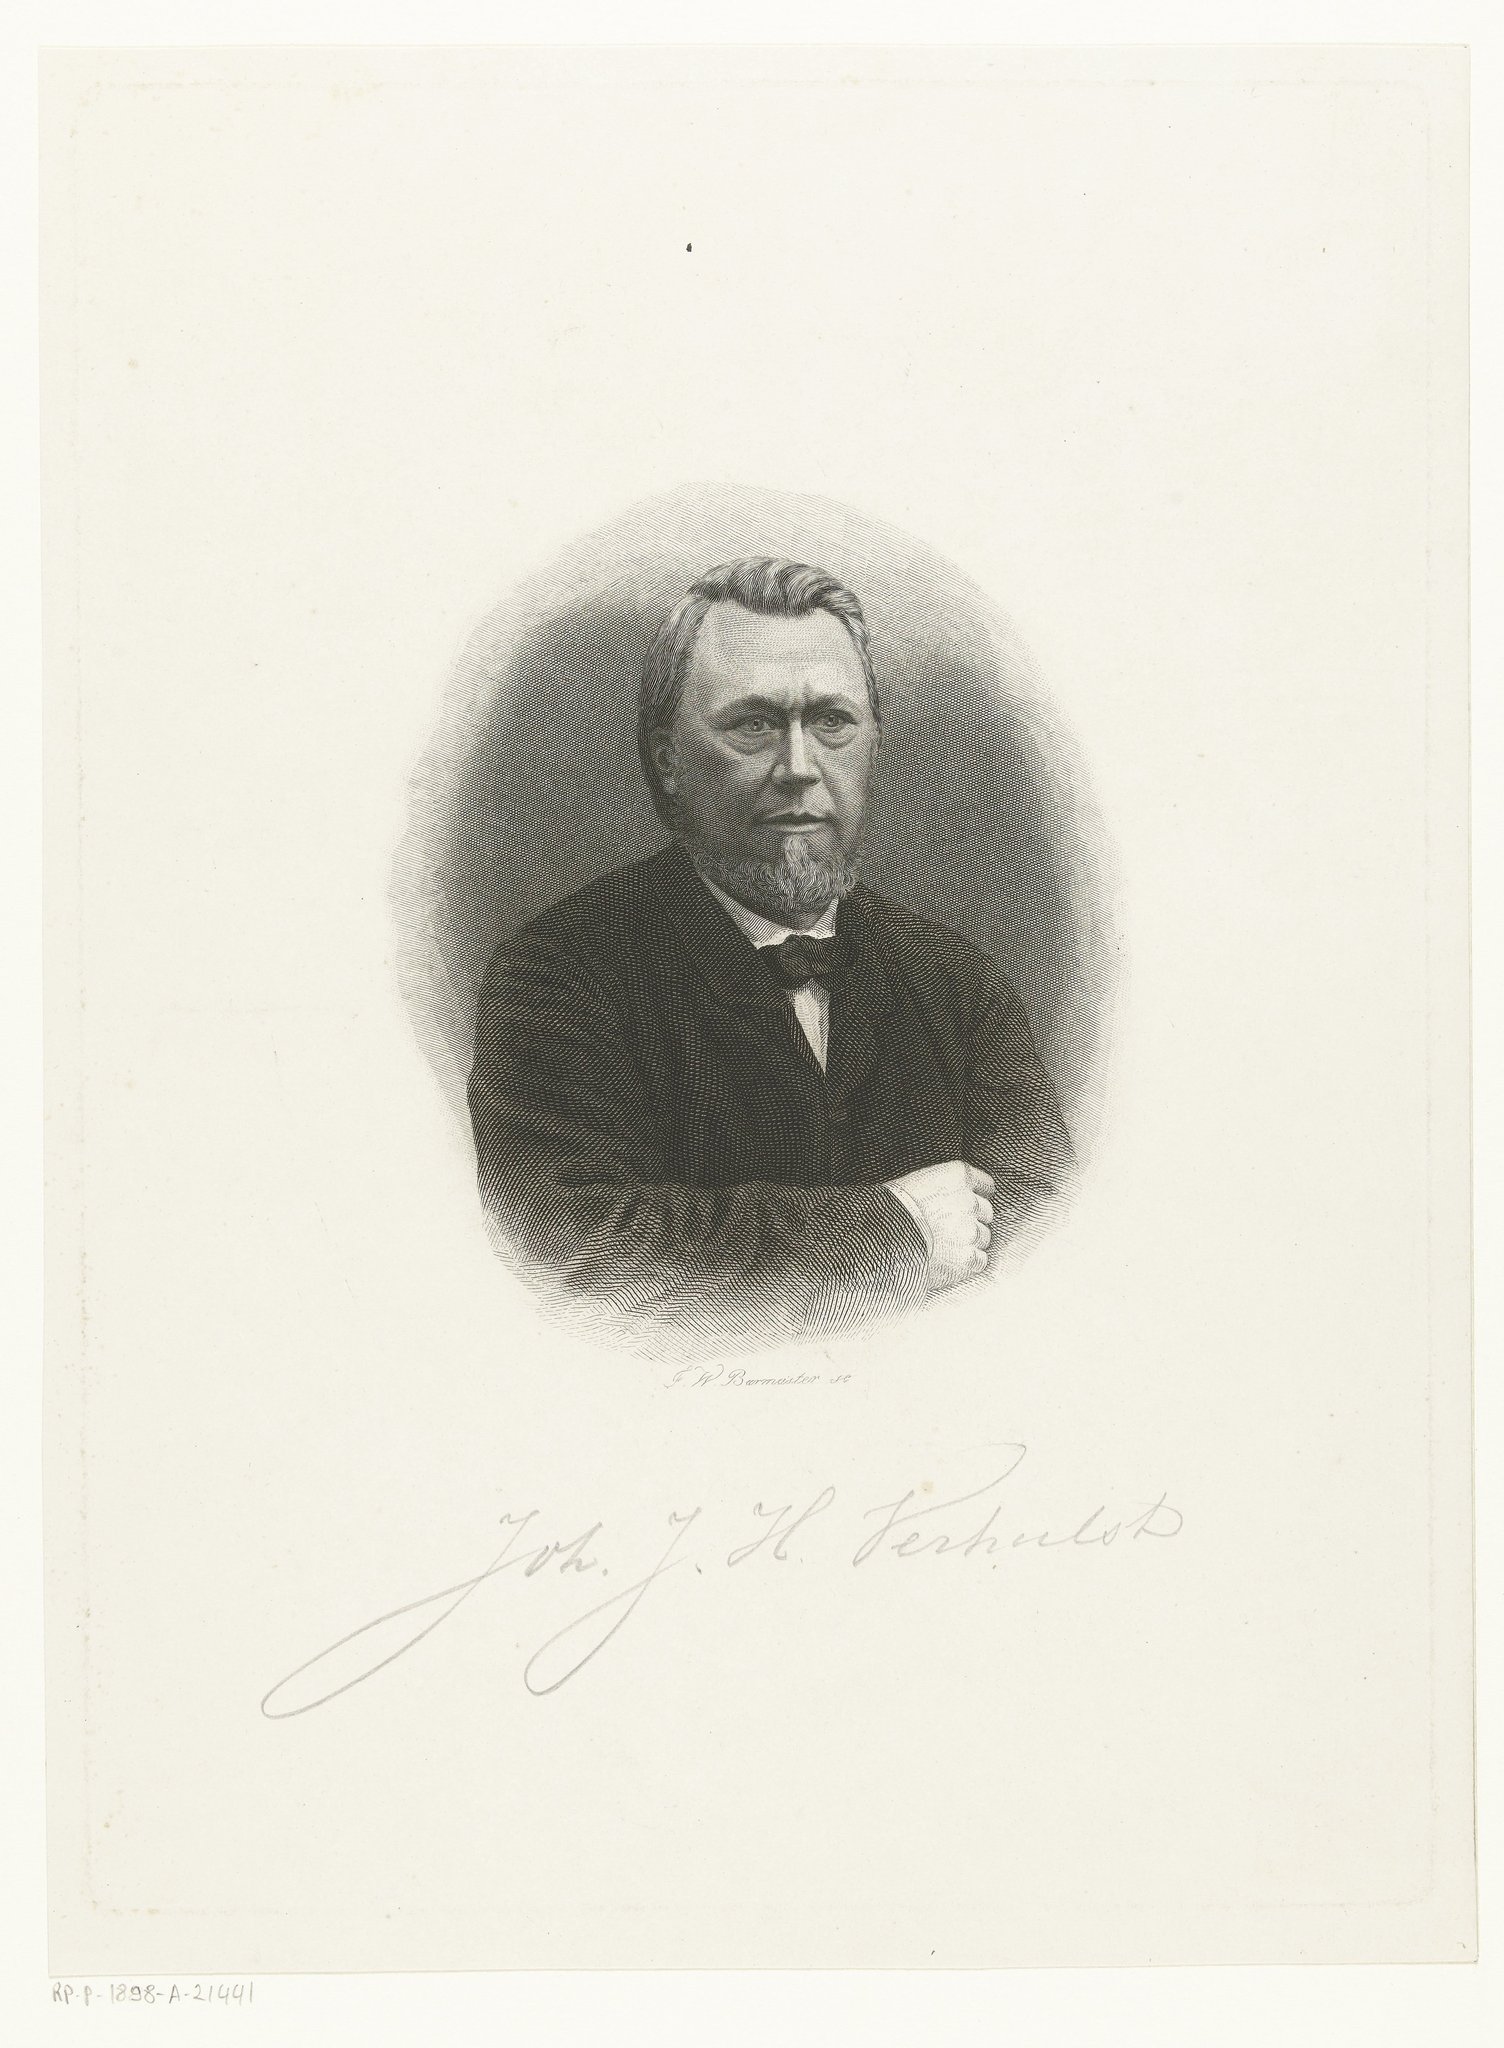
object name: print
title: Portret van Johannes Verhulst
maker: friedrich wilhelm burmeister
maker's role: print maker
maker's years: 1845-1933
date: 1855-1898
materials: paper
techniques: engraving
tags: the hague, johannes verhulst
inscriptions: collector's mark: Lugt 964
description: Portret in ovale lijst van Johannes Verhulst, een Nederlandse dirigent en componist uit de 19de eeuw. Buste naar rechts. Met de handtekening van de geportretteerde.